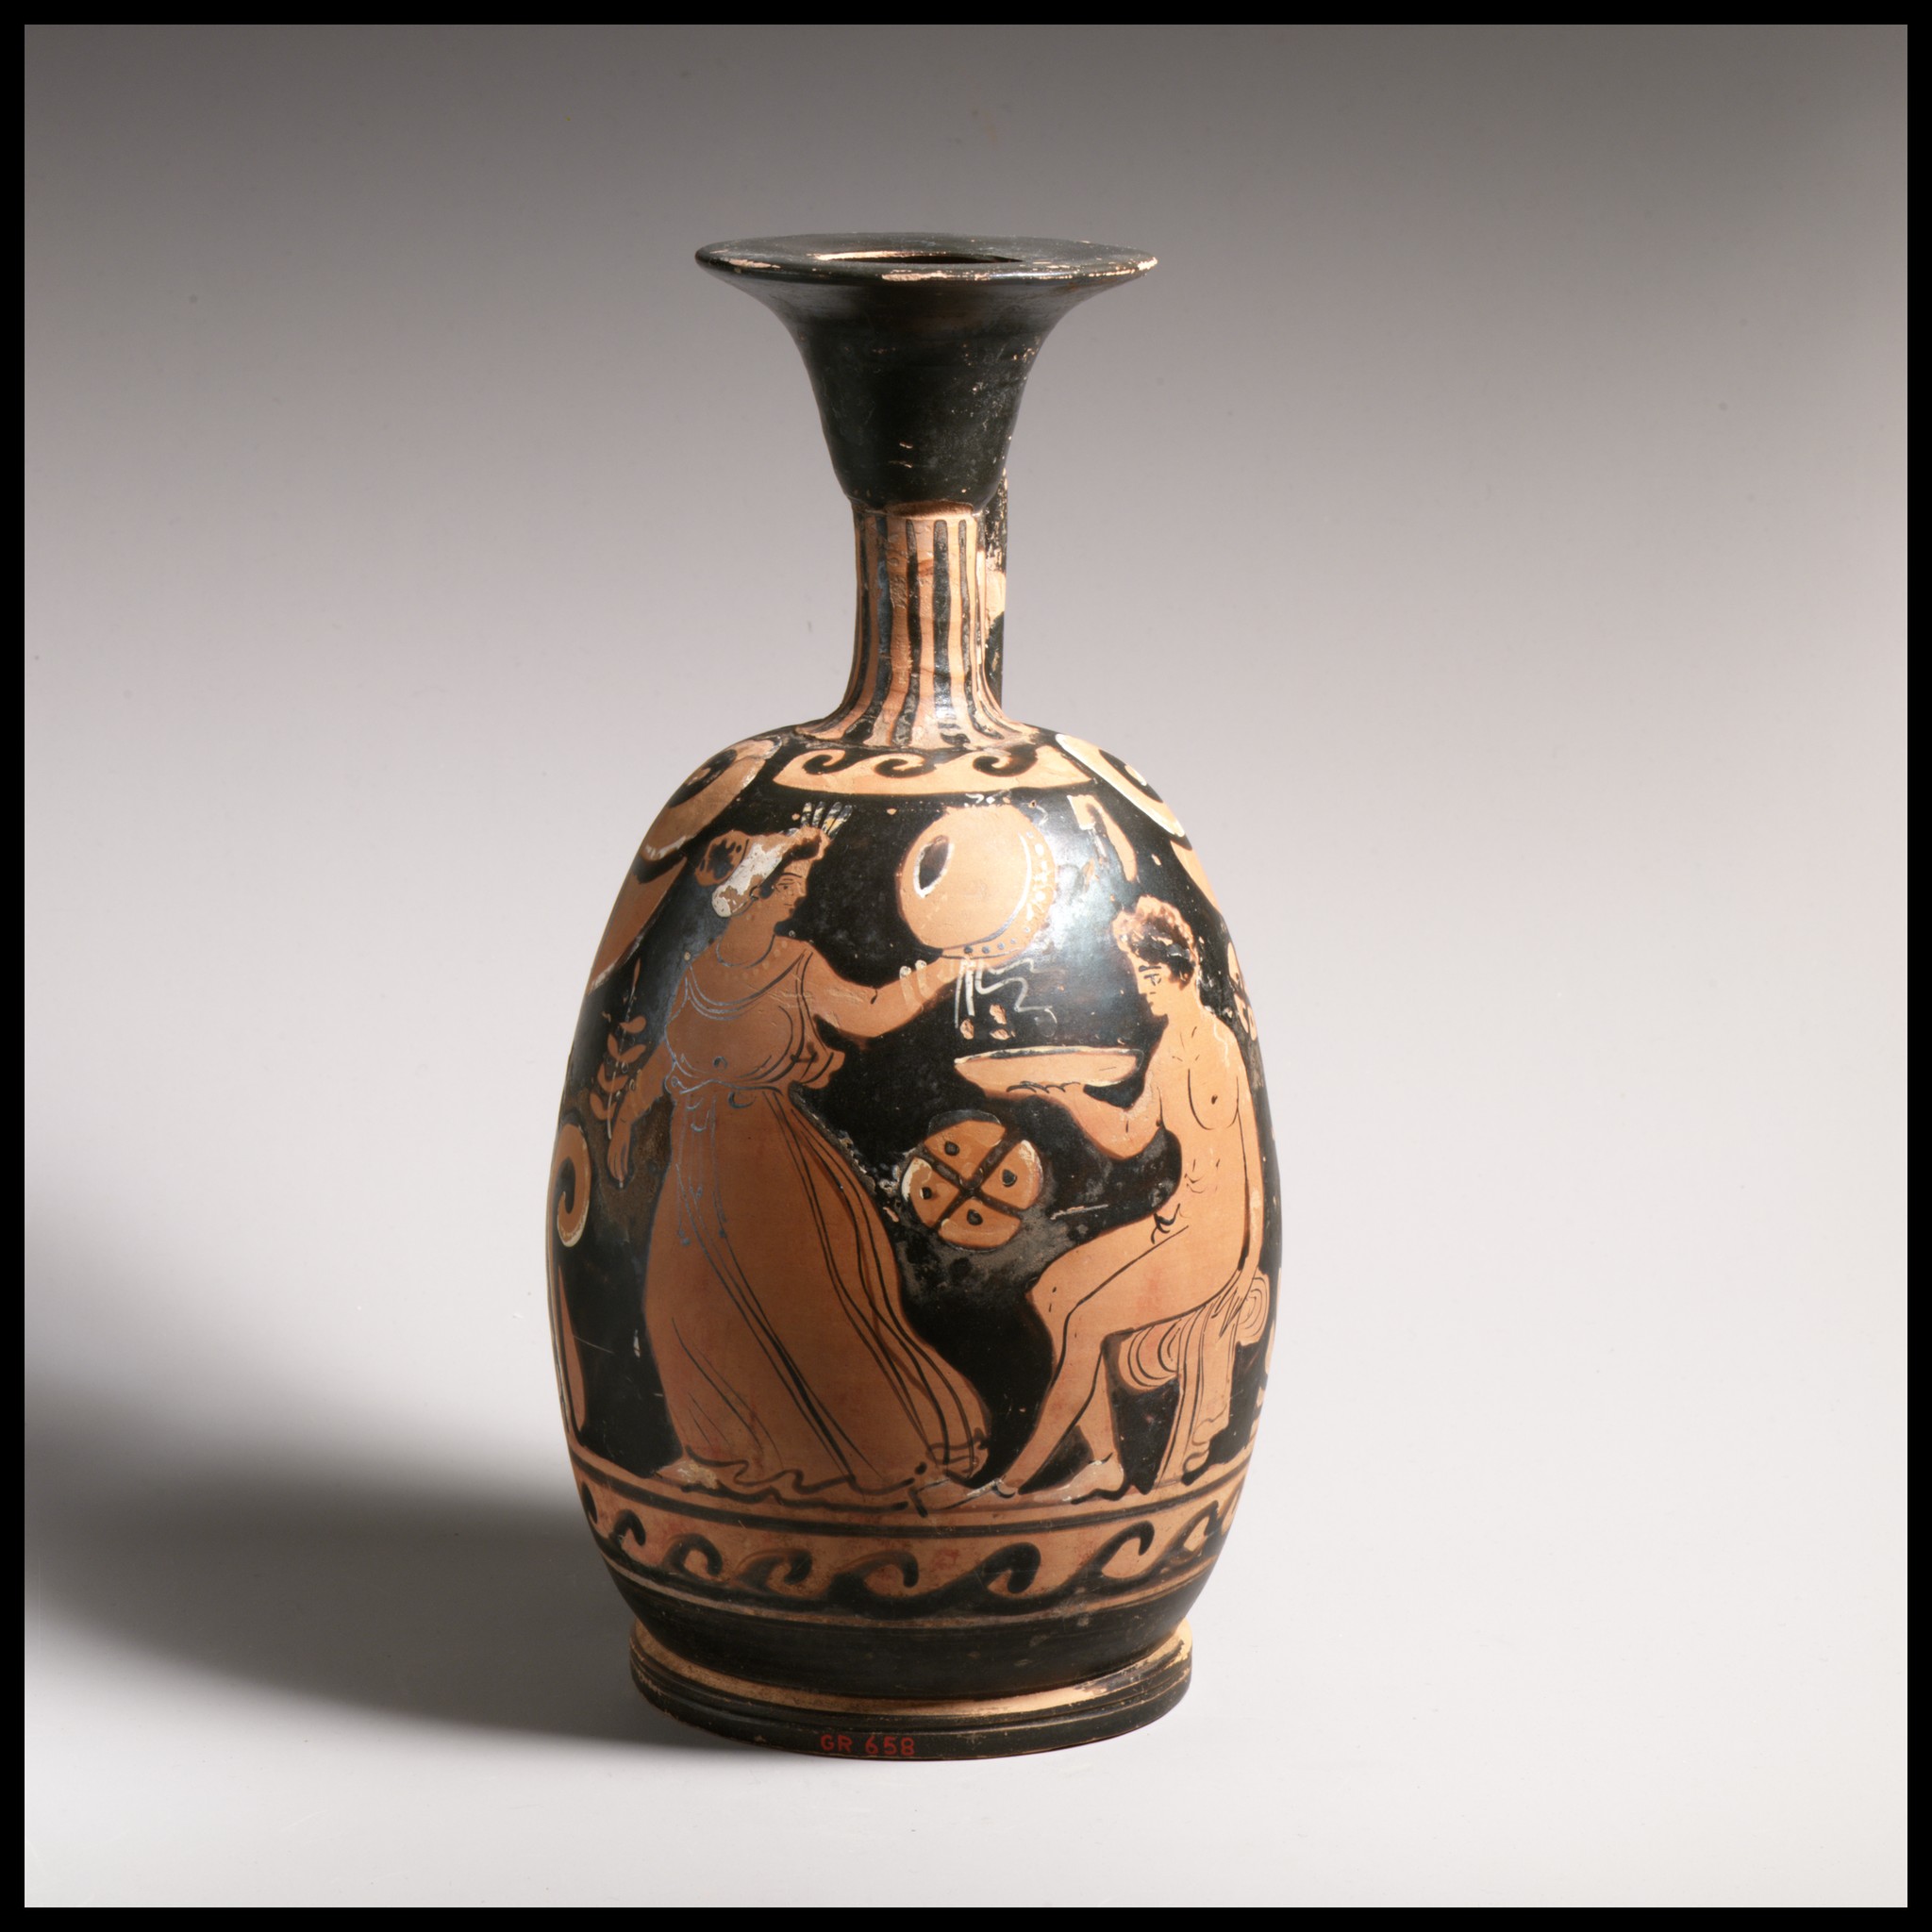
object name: squat lekythos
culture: greek or south italian or campanian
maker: apz painter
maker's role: artist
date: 330-320 BCE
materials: terracotta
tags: men,women